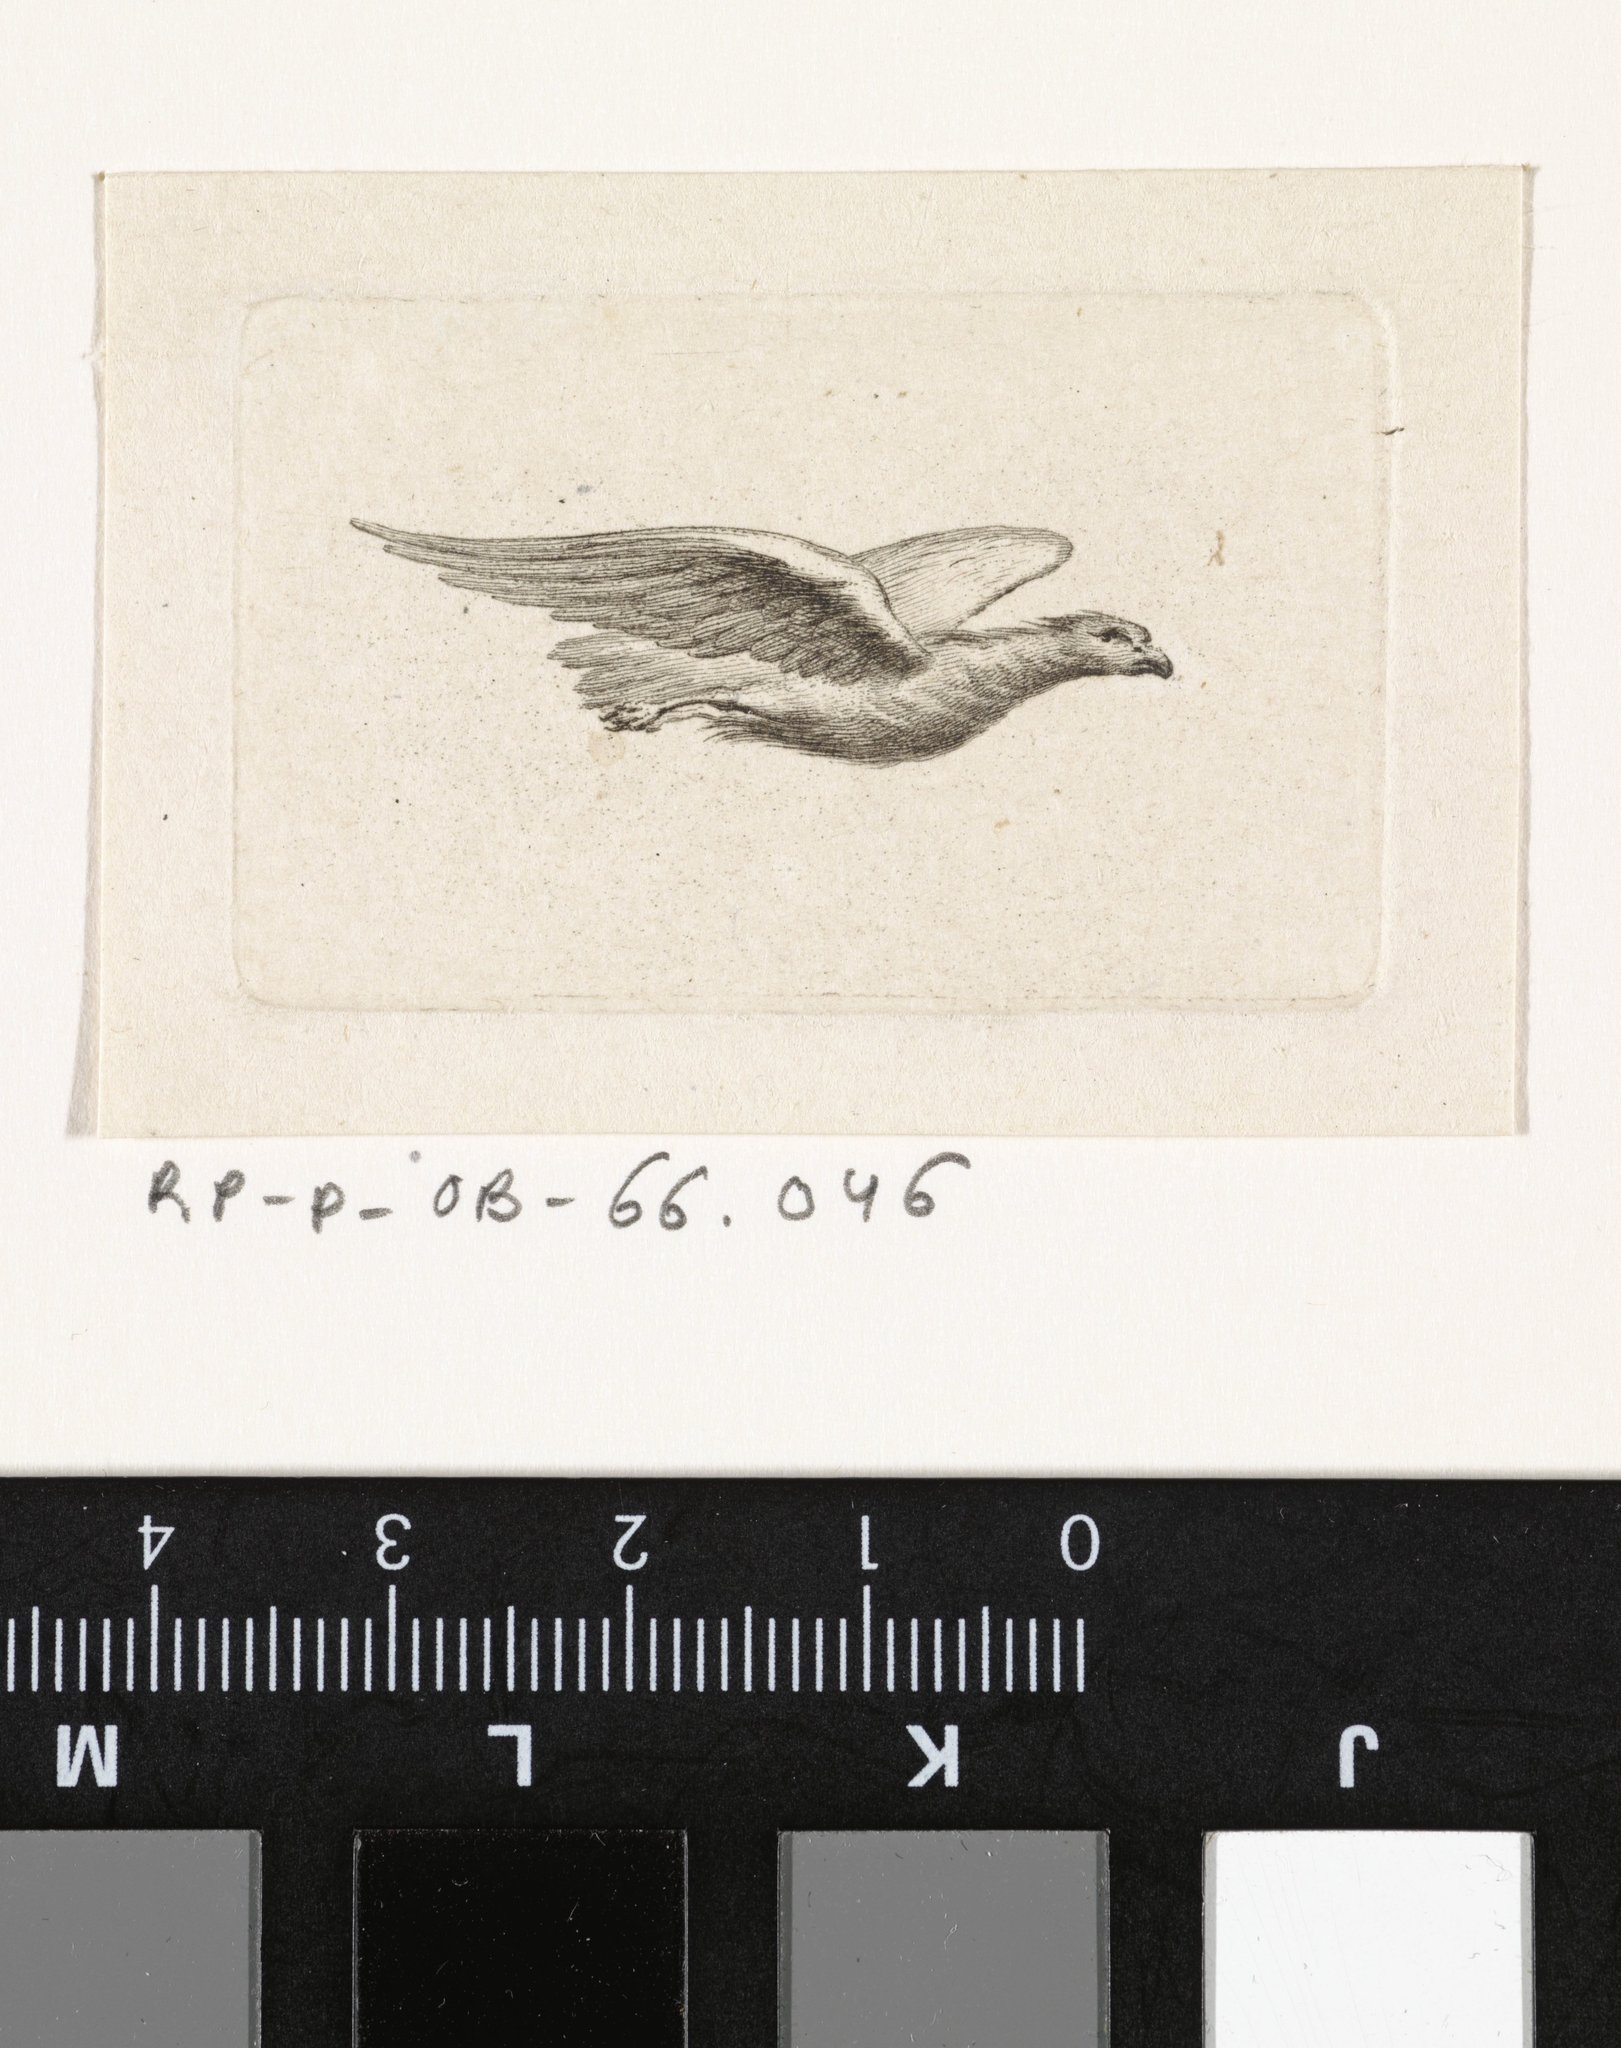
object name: print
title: Vliegende roofvogel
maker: reinier vinkeles (i)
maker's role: draughtsman, print maker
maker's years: 1741-1816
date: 1751-1816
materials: paper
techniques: engraving, etching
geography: amsterdam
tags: predatory birds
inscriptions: collector's mark: Lugt 240